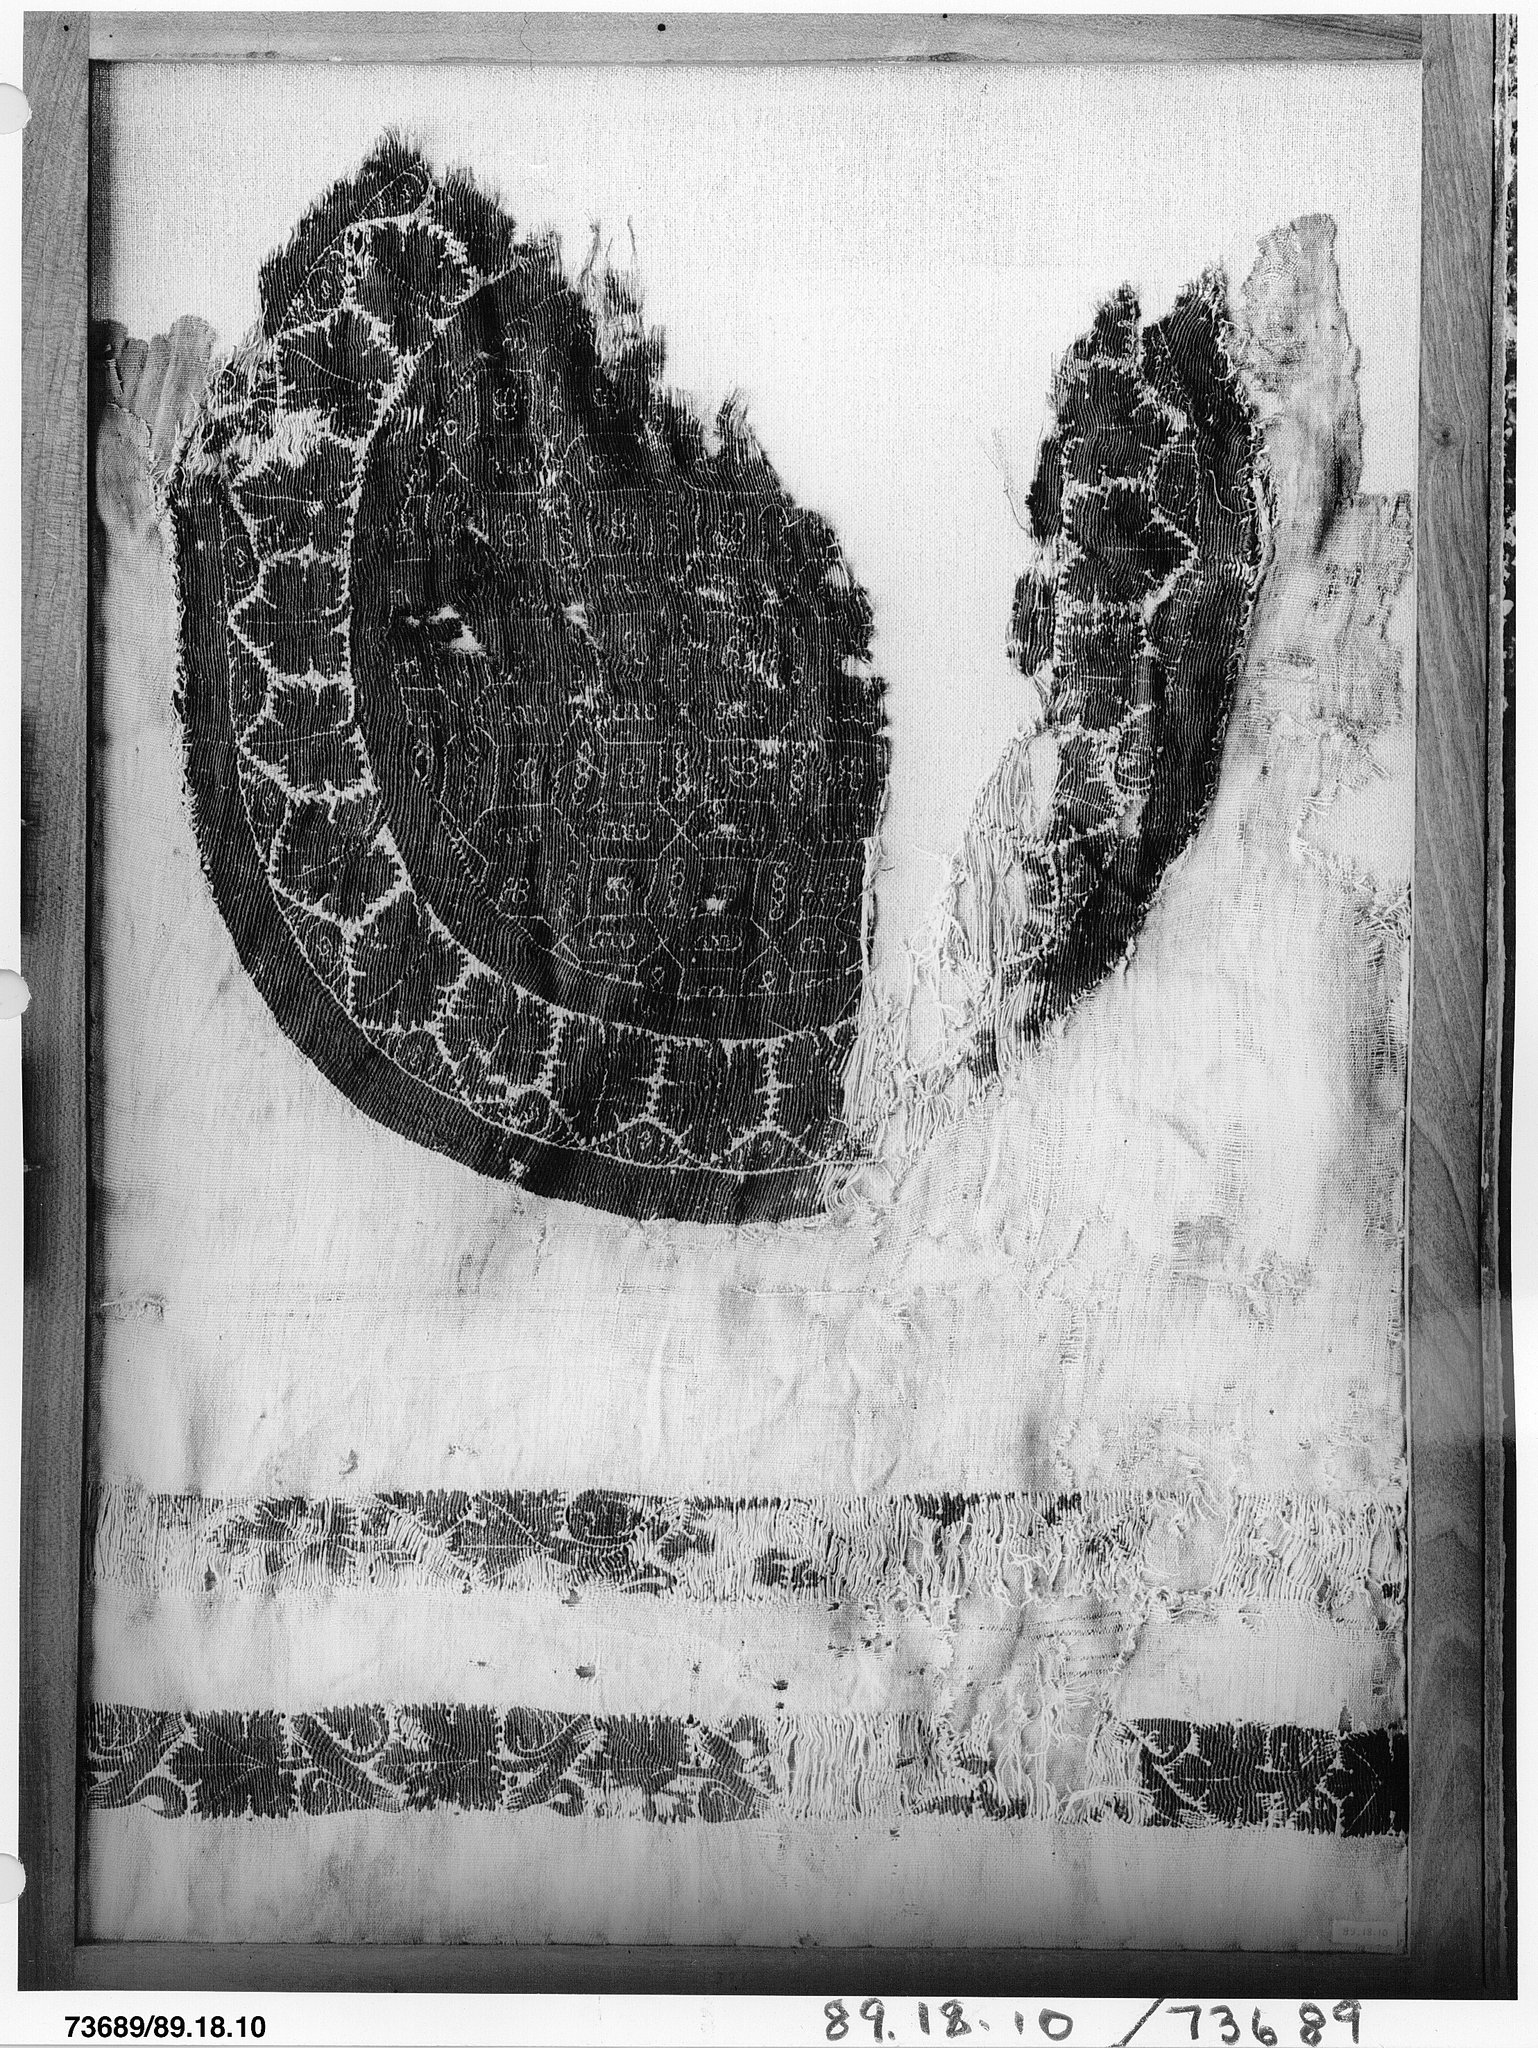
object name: textile fragment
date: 201-400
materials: linen, wool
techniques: weave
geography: egypt